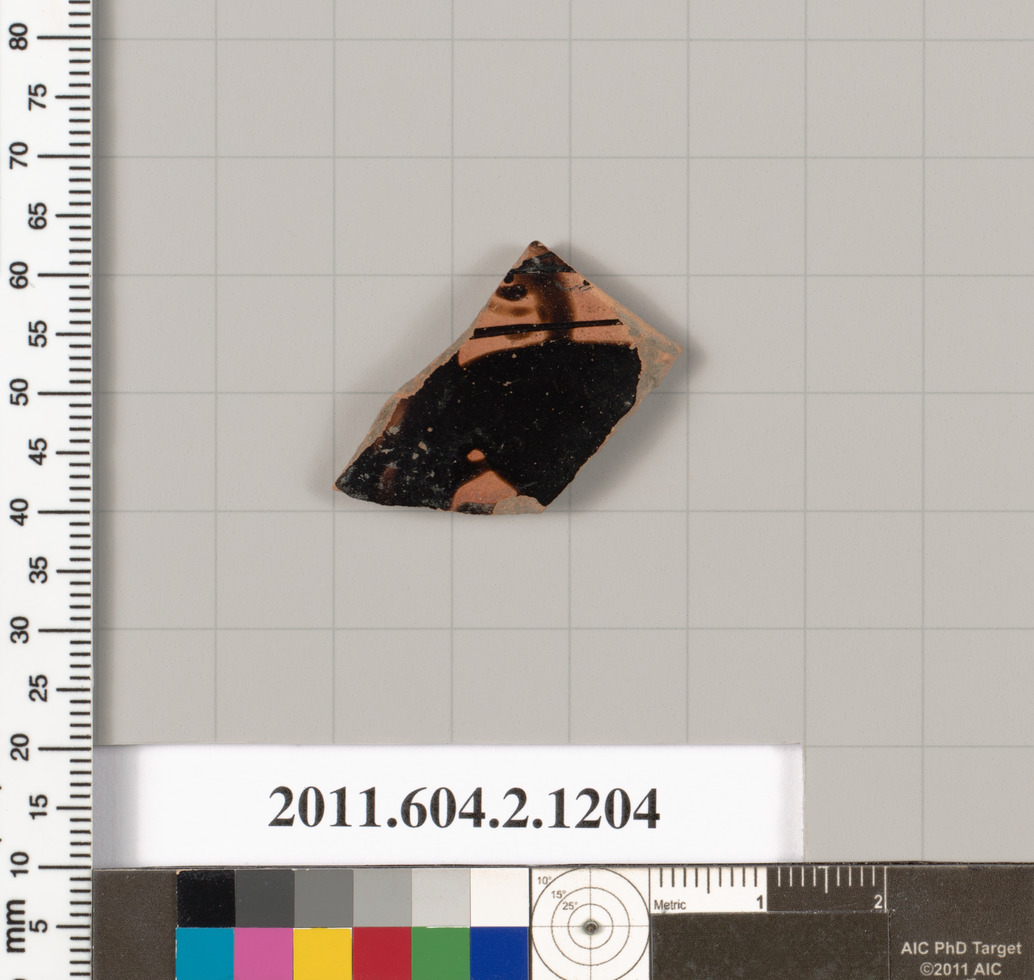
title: Terracotta fragment from an open shape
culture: greek, attic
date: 500-301 BCE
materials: terracotta